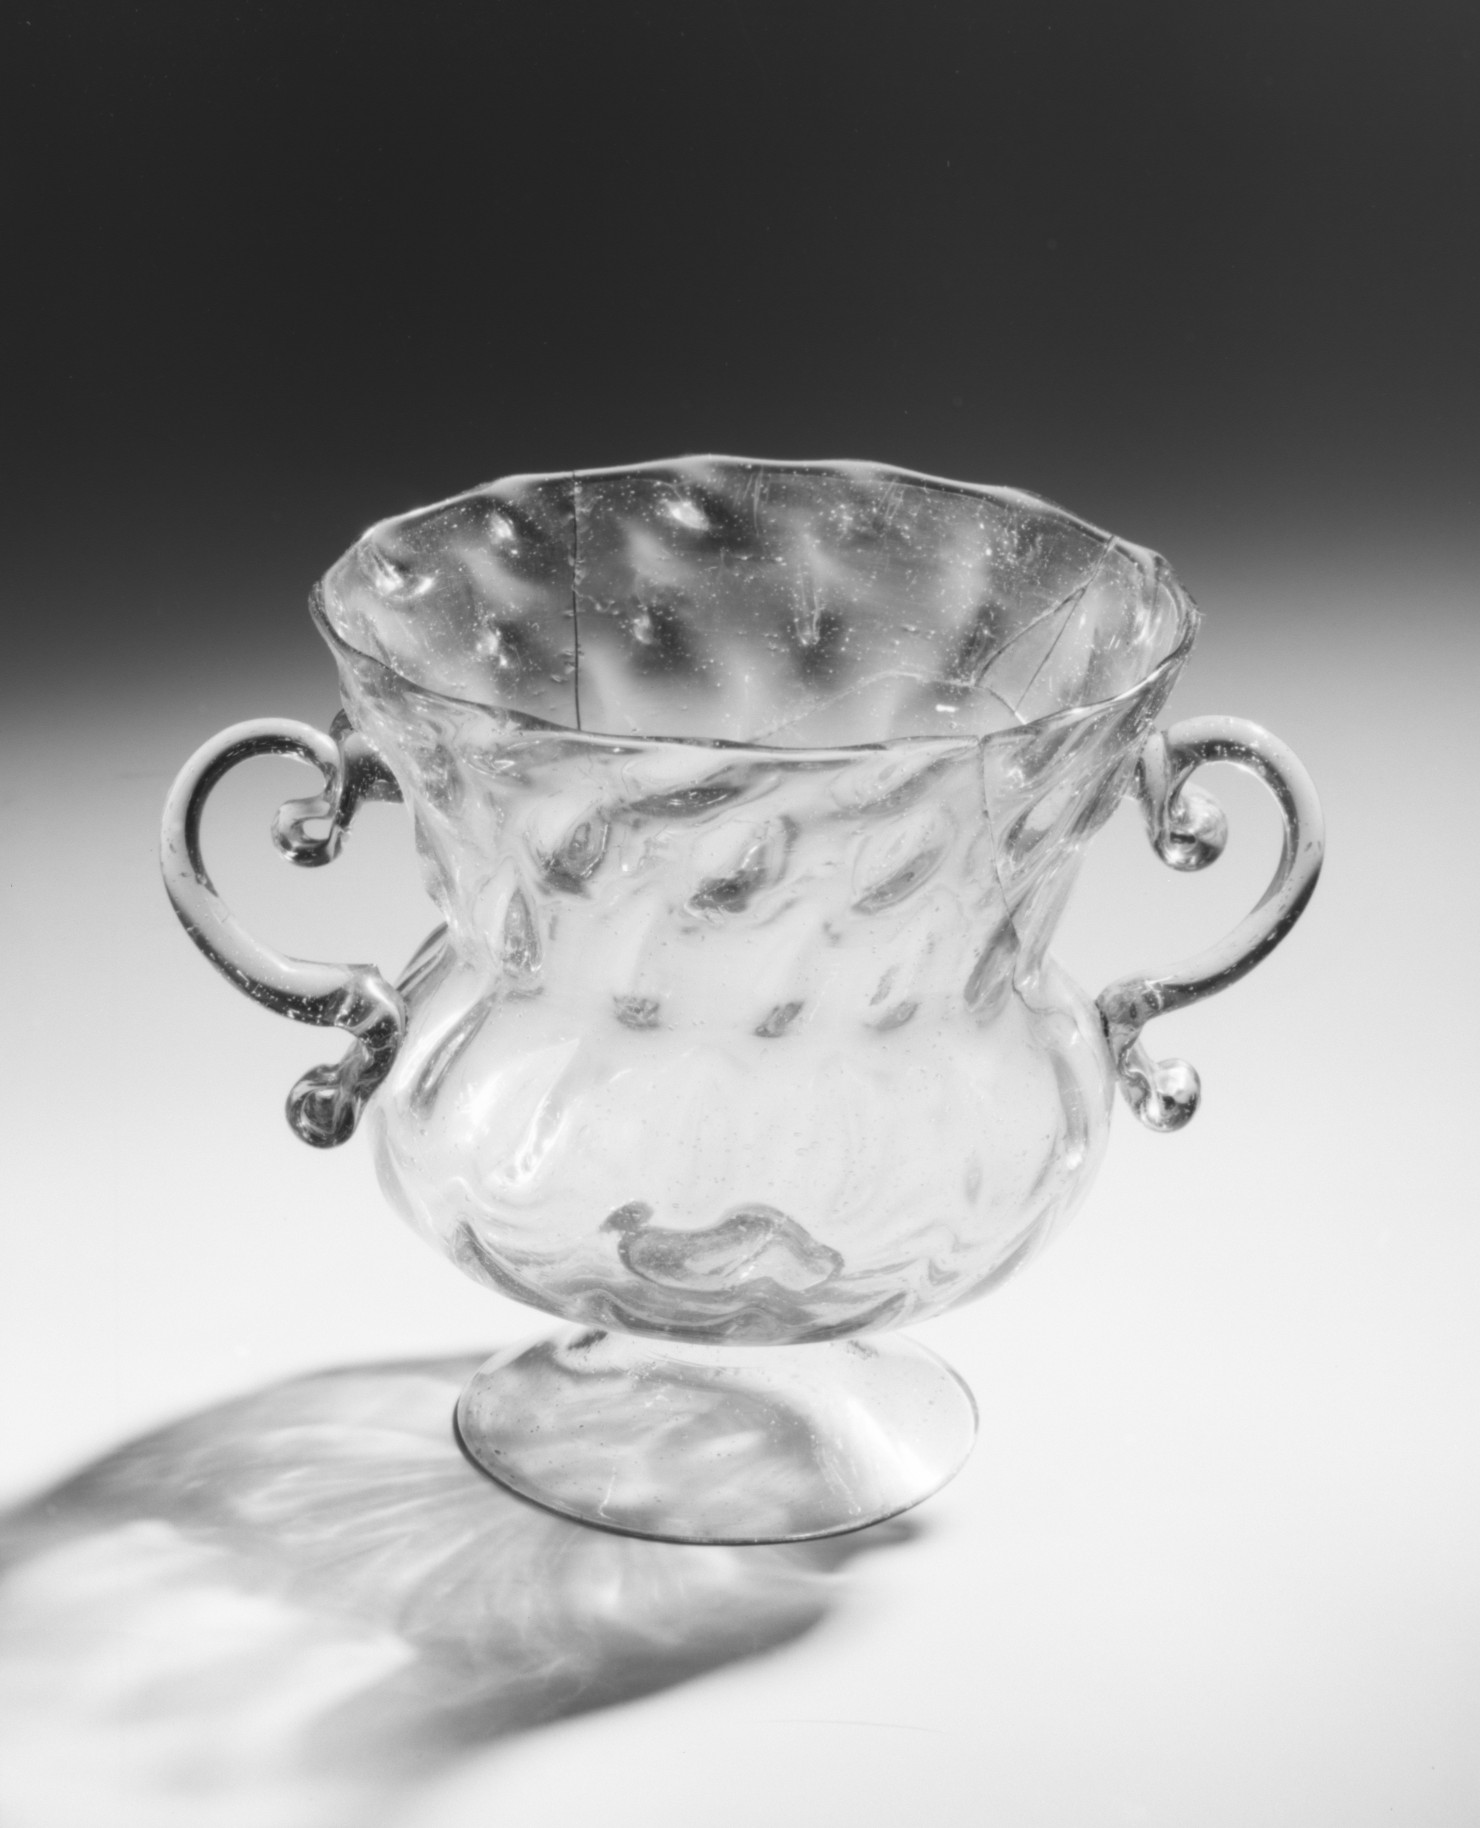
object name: cup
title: Cup on foot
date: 1601-1733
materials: glass